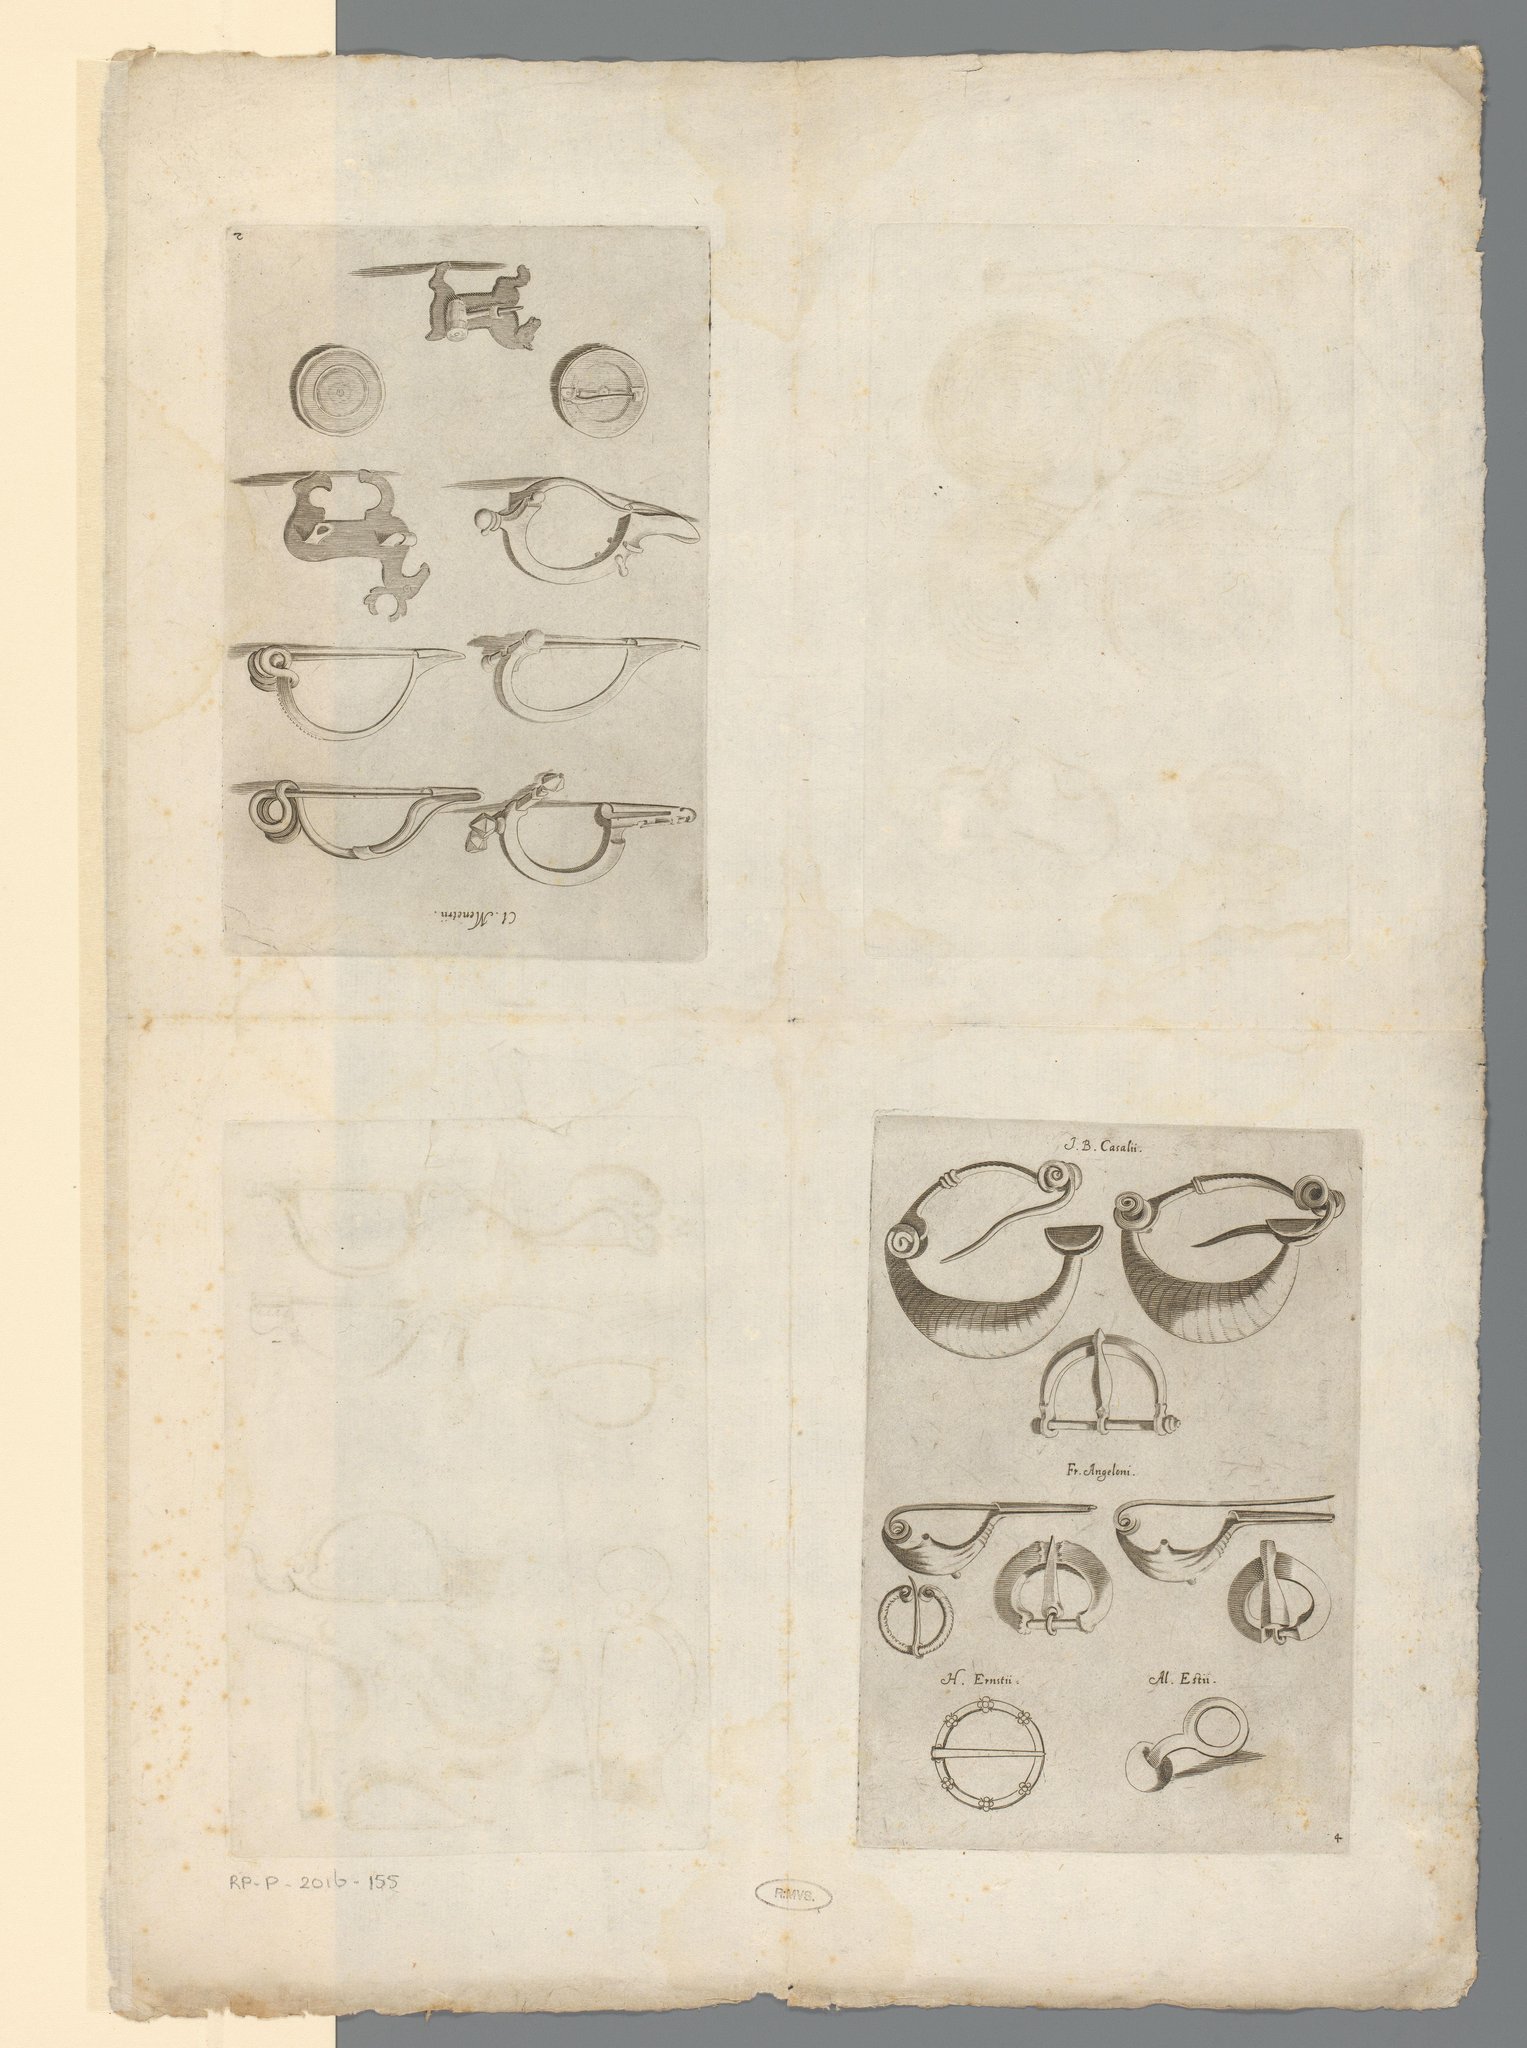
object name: print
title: Antieke fibulae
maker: Anonymous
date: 1650-1700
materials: paper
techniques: etching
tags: fibula, safety pin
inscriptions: collector's mark: Lugt 2228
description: Twee prenten op een blad met diverse antieke fibulae. Met naamsvermelding van Johannes Baptista Casalius, Francesco Angeloni, Henricus Ernstius, Al. Estius en Claudius Menetrius.